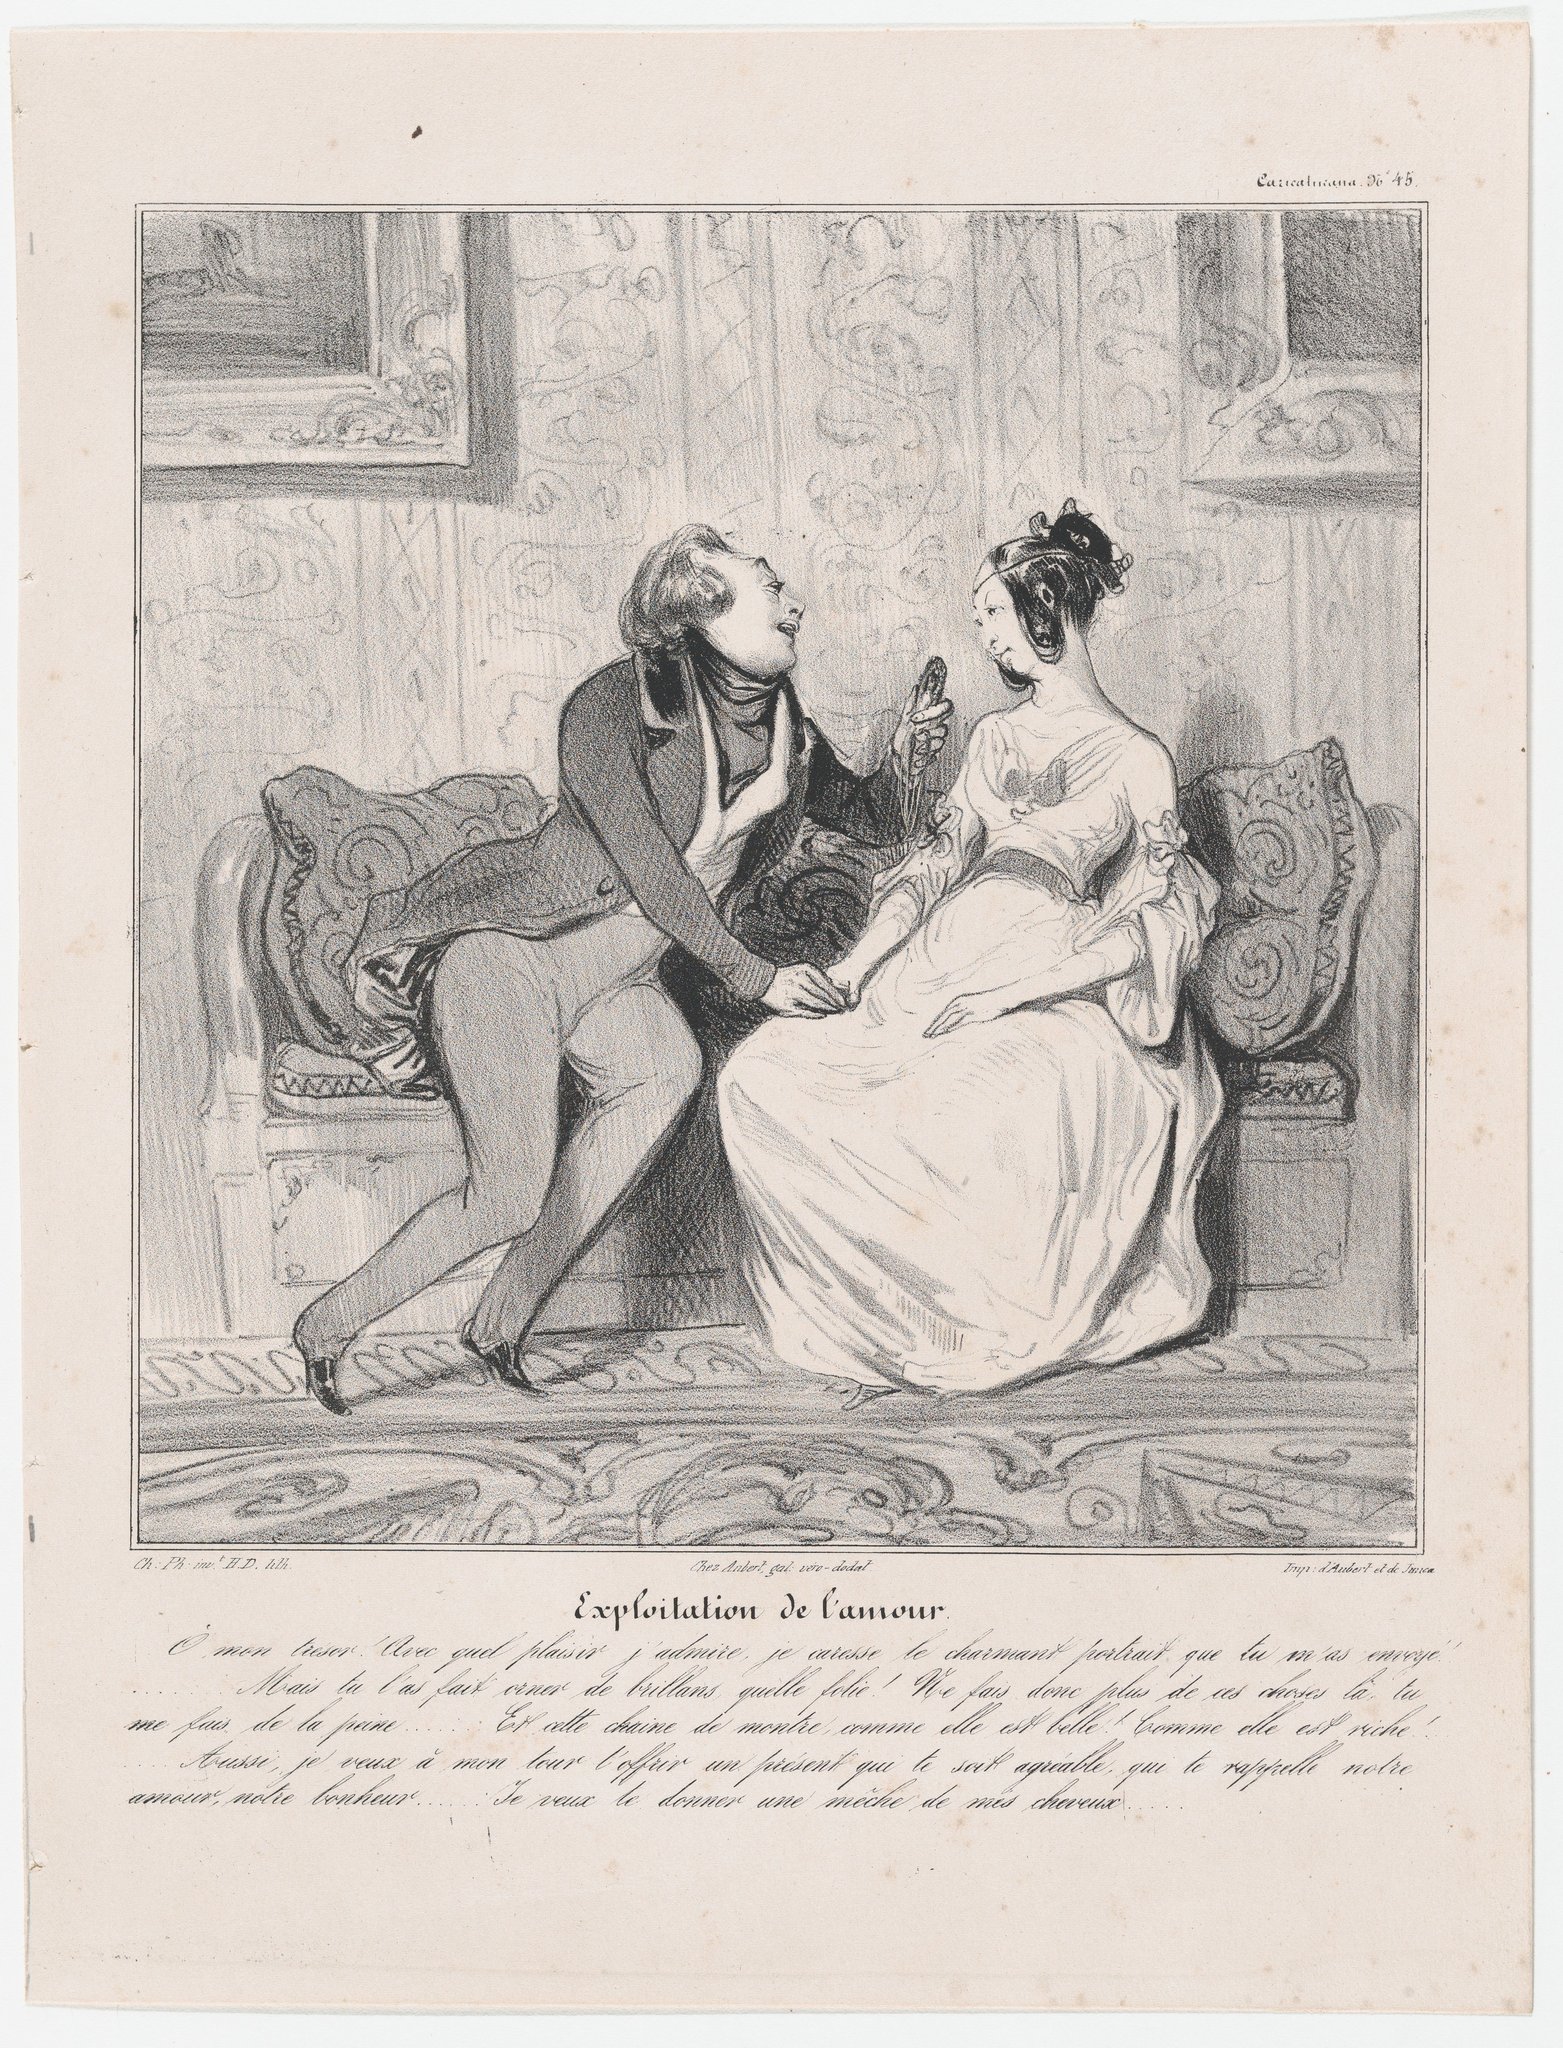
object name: print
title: Plate 45: Exploitation of love, from 'Caricaturana,' published in Les Robert Macaires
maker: honoré daumier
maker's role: artist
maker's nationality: french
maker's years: 1808-1879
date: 1838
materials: paper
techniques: lithograph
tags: satire,men,women